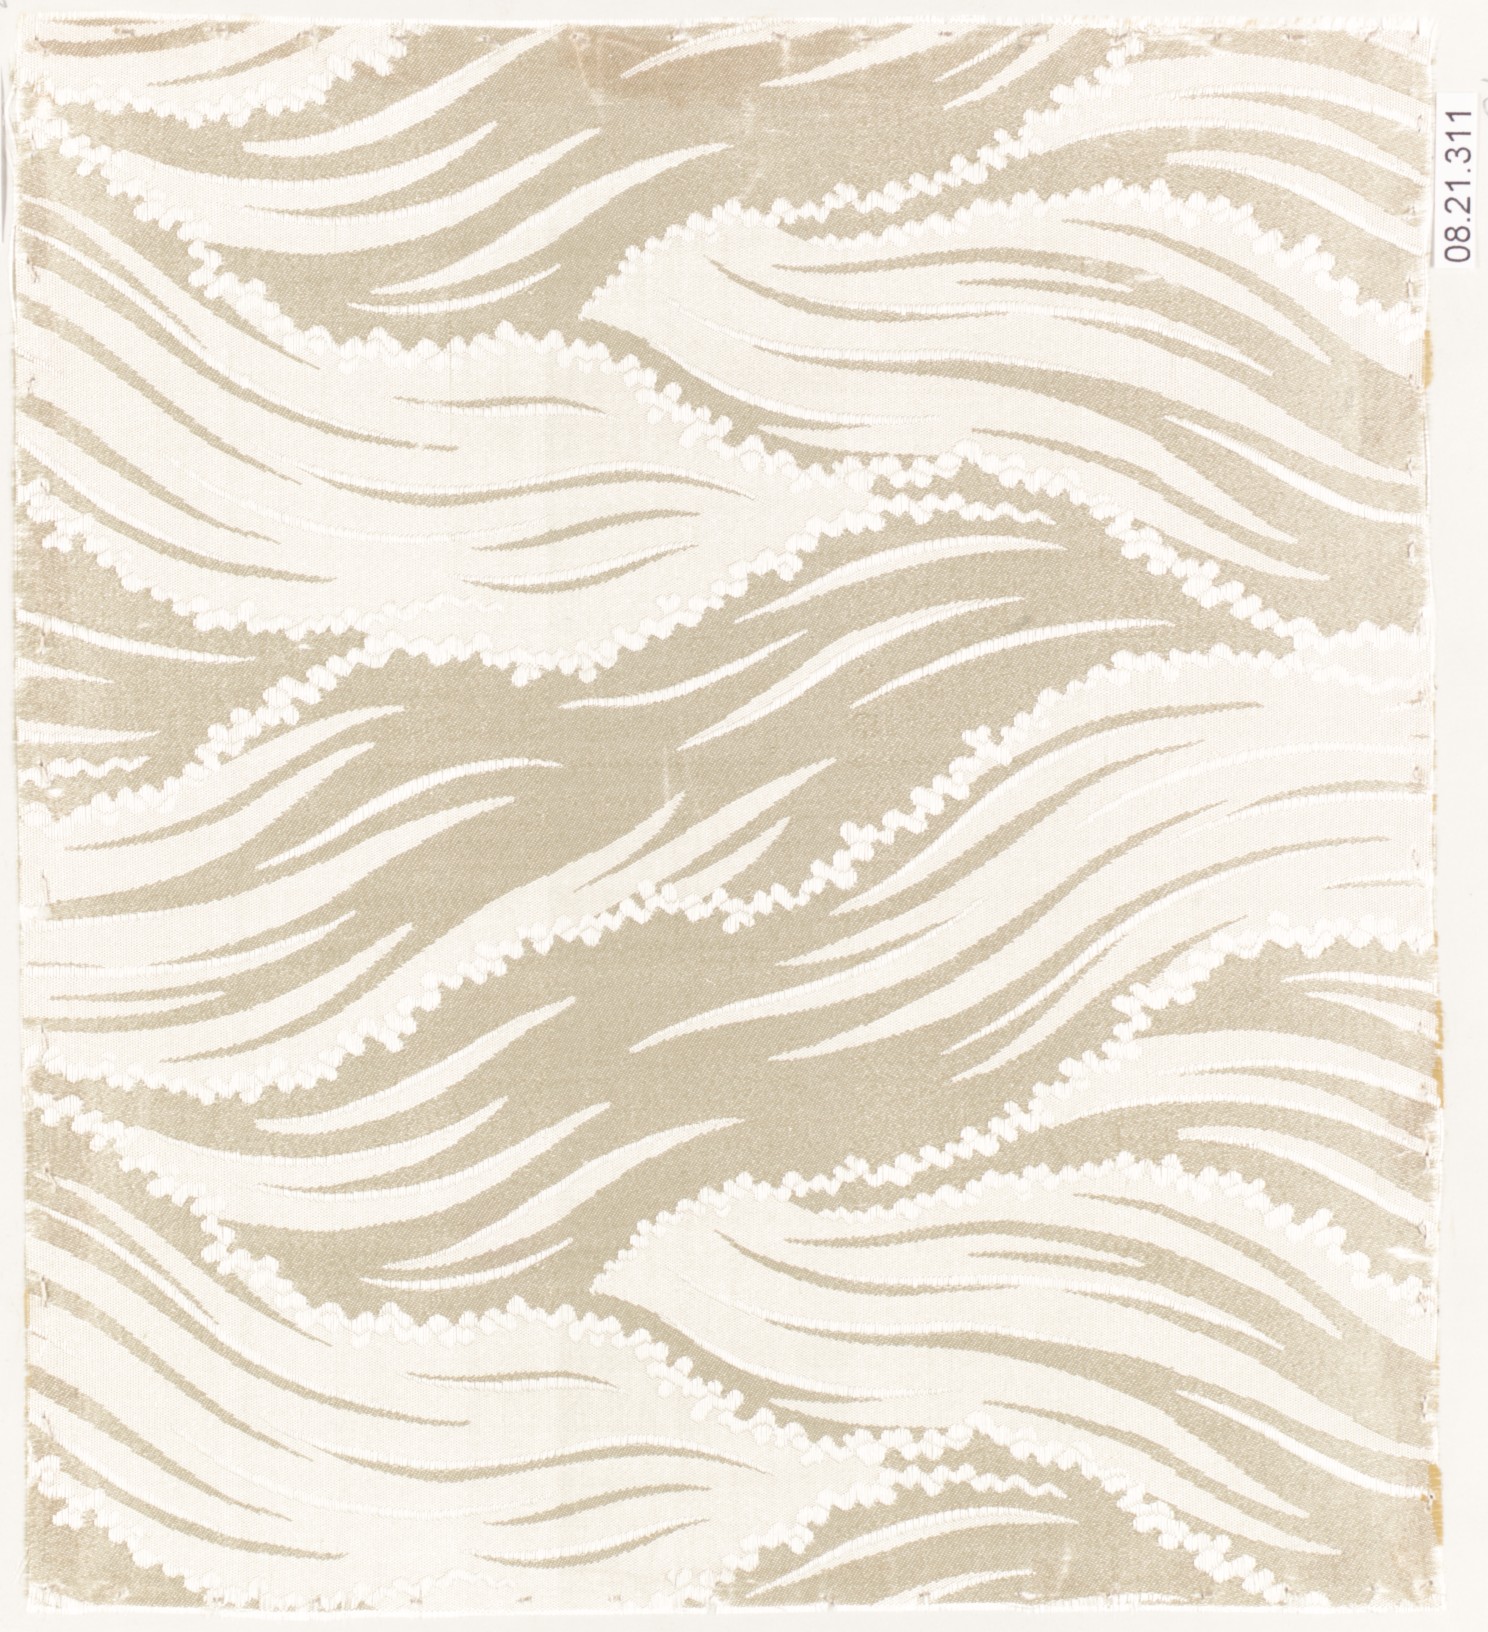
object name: textile sample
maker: Anonymous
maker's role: designer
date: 1900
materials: silk